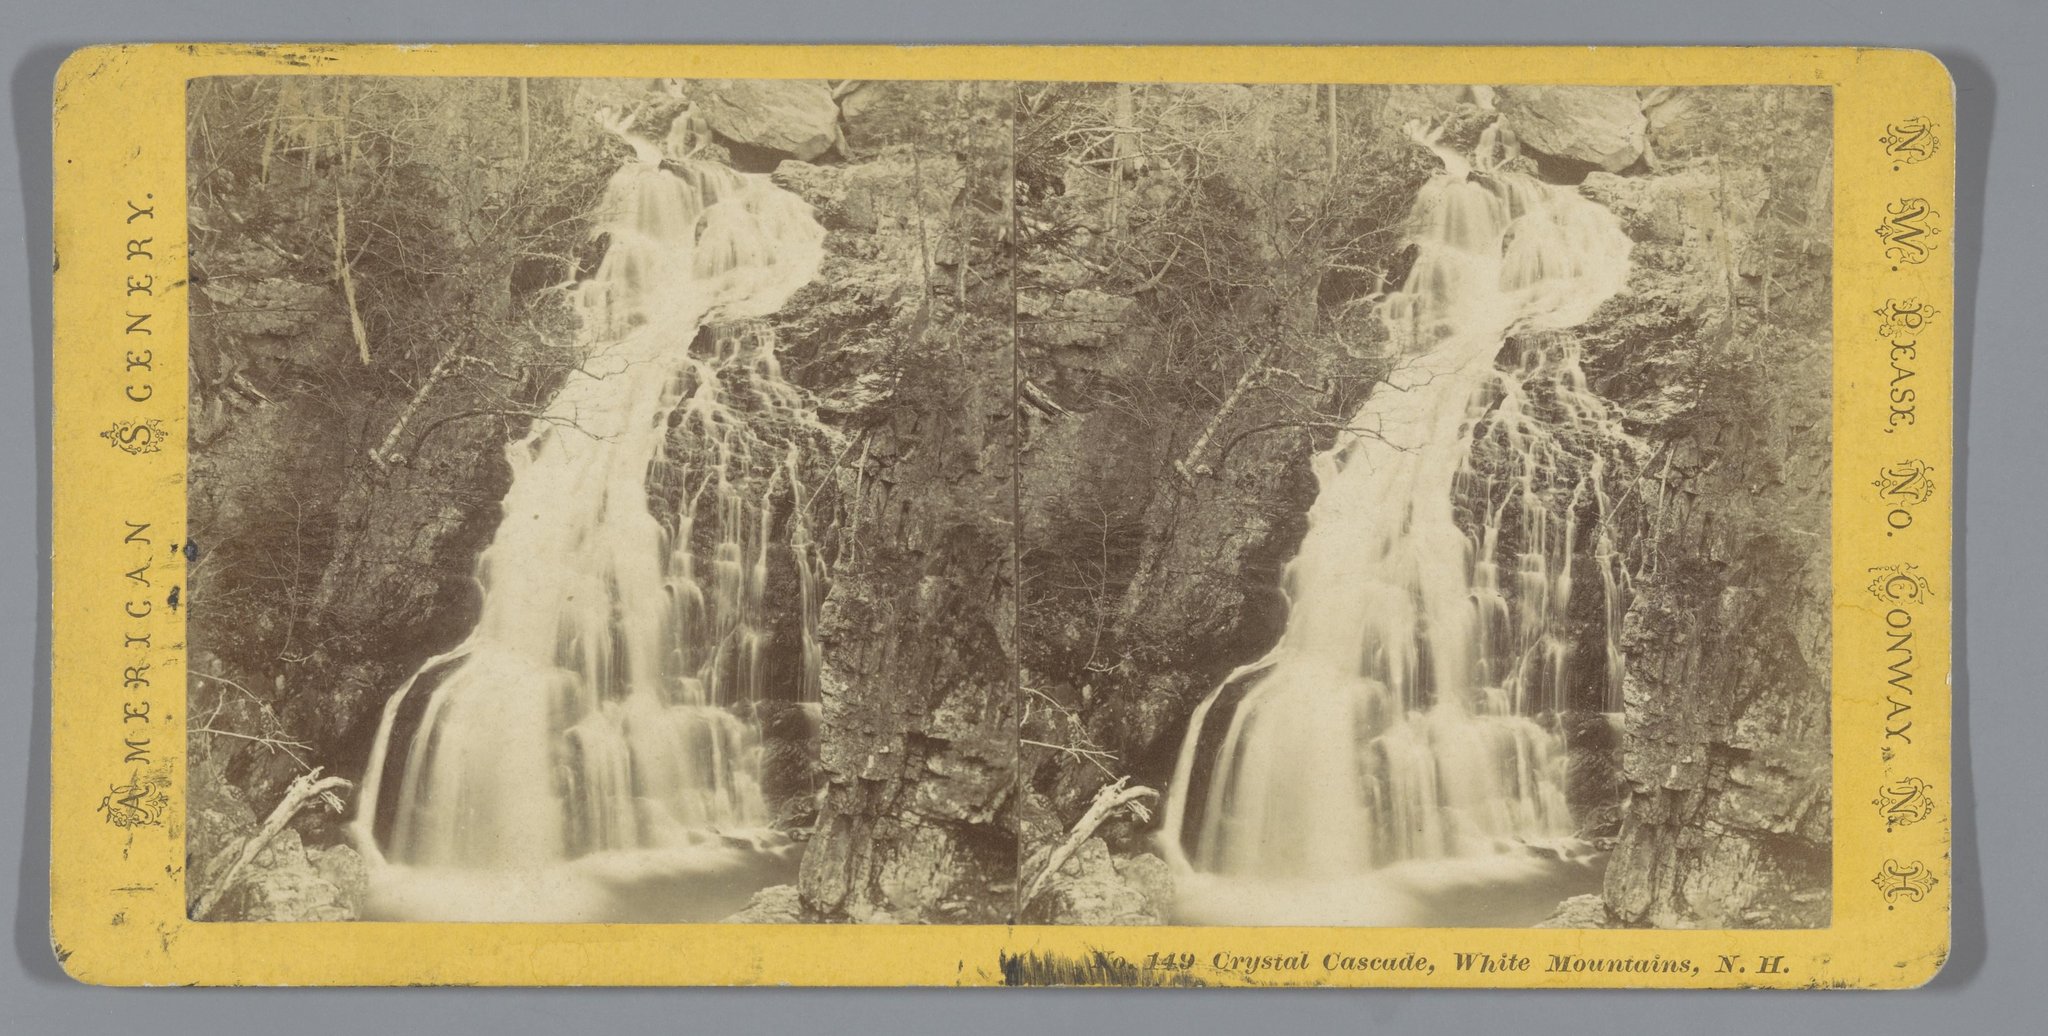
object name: stereograph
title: Waterval bij de White Mountains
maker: n.w. pease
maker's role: fotograaf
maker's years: 1836-1918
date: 1870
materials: cardboard, paper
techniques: albumen print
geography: white mountains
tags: waterfall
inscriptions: number: ‘149’